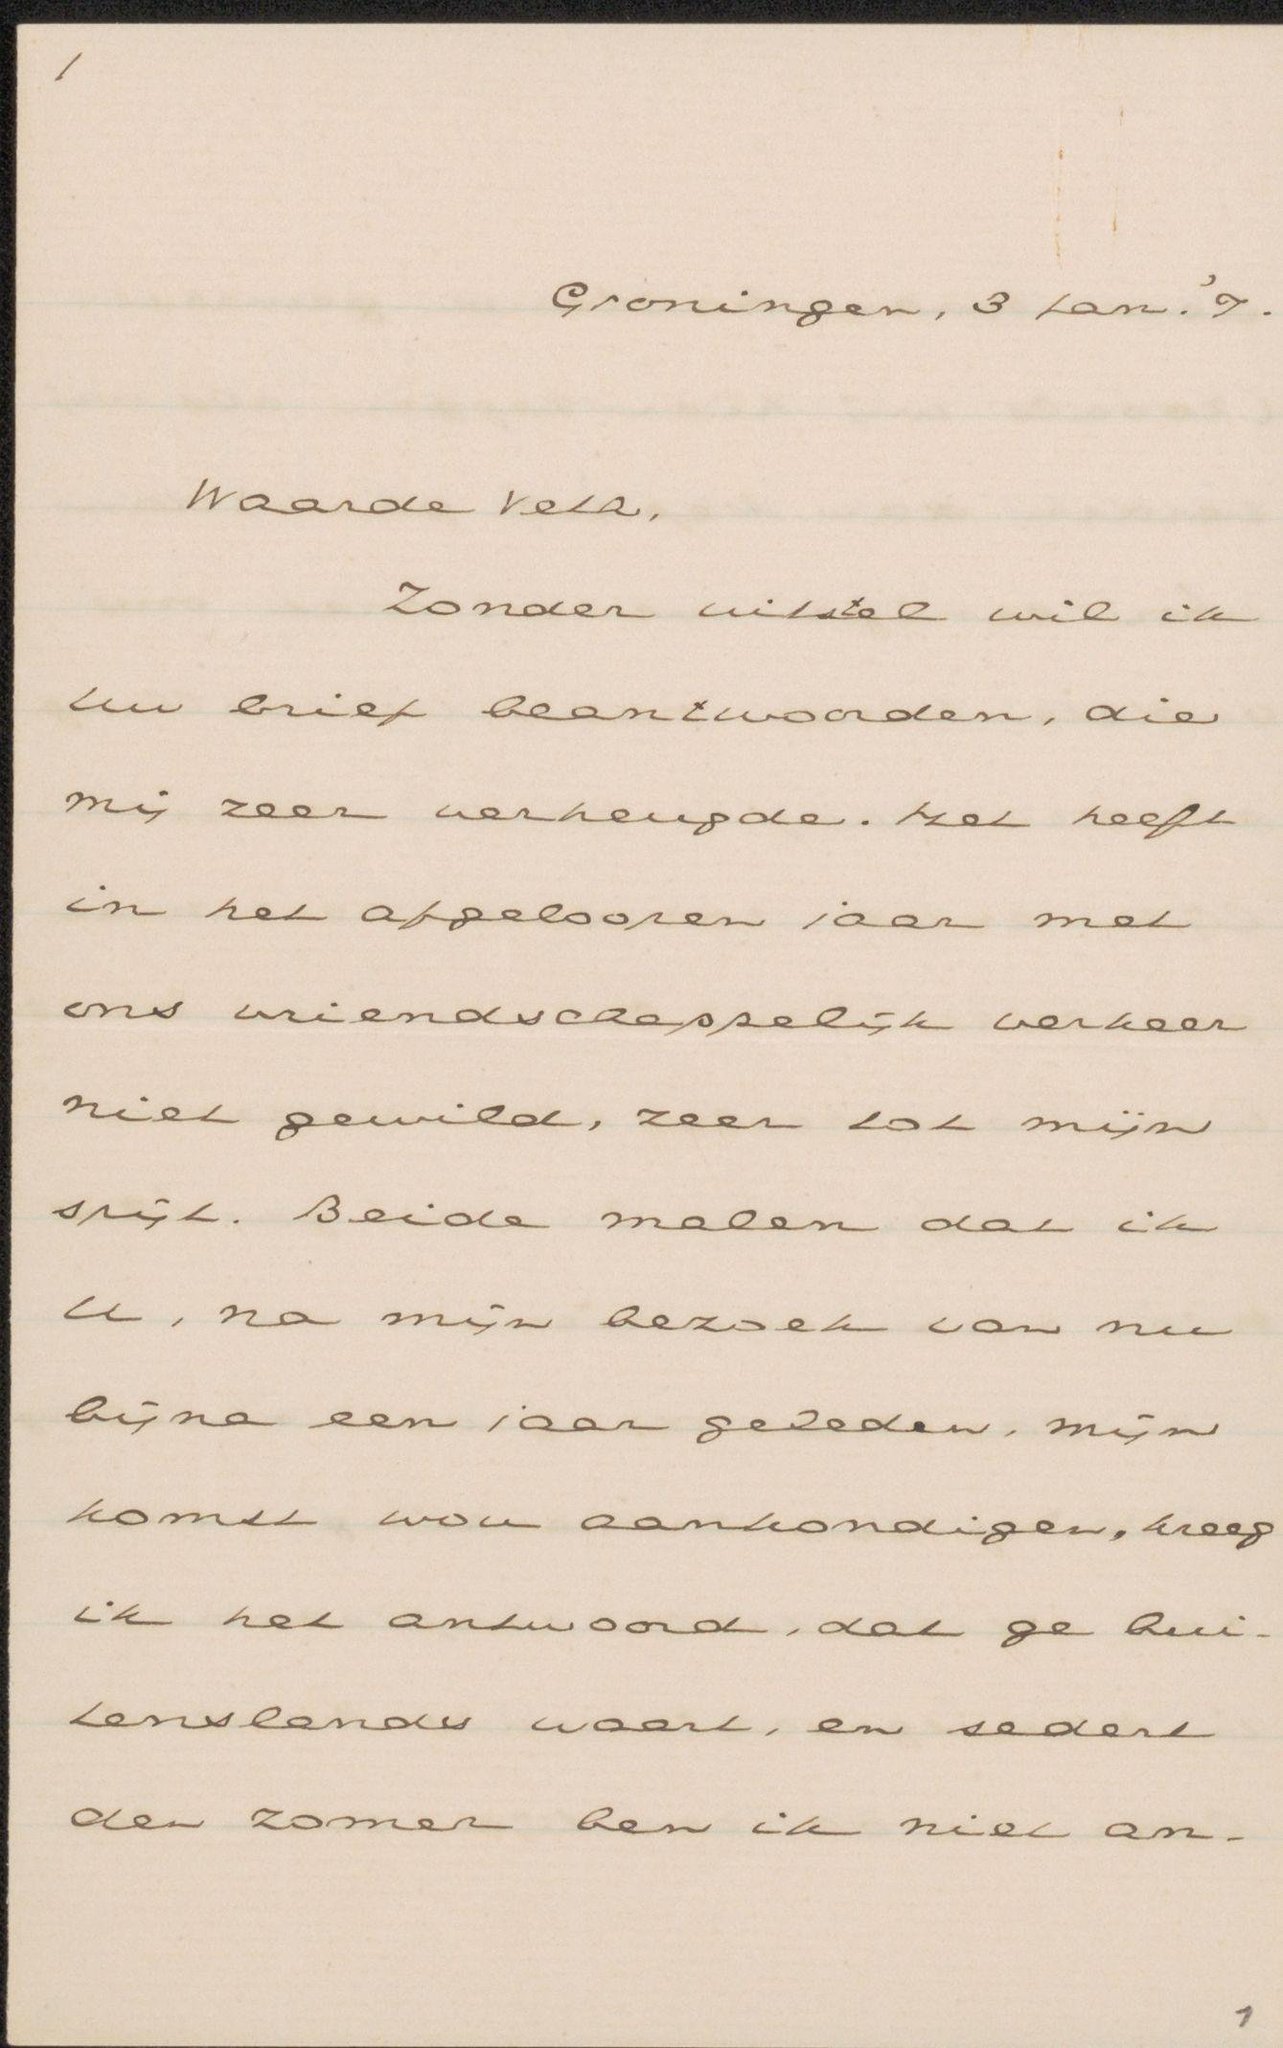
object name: letter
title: Brief aan Jan Veth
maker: johan huizinga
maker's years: 1872-1945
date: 1907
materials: ink, paper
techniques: pen, writing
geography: groningen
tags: dordrecht, painter, print maker, draughtsman, designer, jan veth, leiden, the hague, hendricus petrus bremmer, den helder, samuel muller (1848-1922), jonkheer jan six, haarlem, amsterdam, antonius gerardus van hamel, andré jolles, hoorn (north holland), utrecht, gerhard wilhelm kernkamp, herman theodoor colenbrander, johan hendrik gallée, germany, middelburg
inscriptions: collector's mark: ‘RPK’, watermark